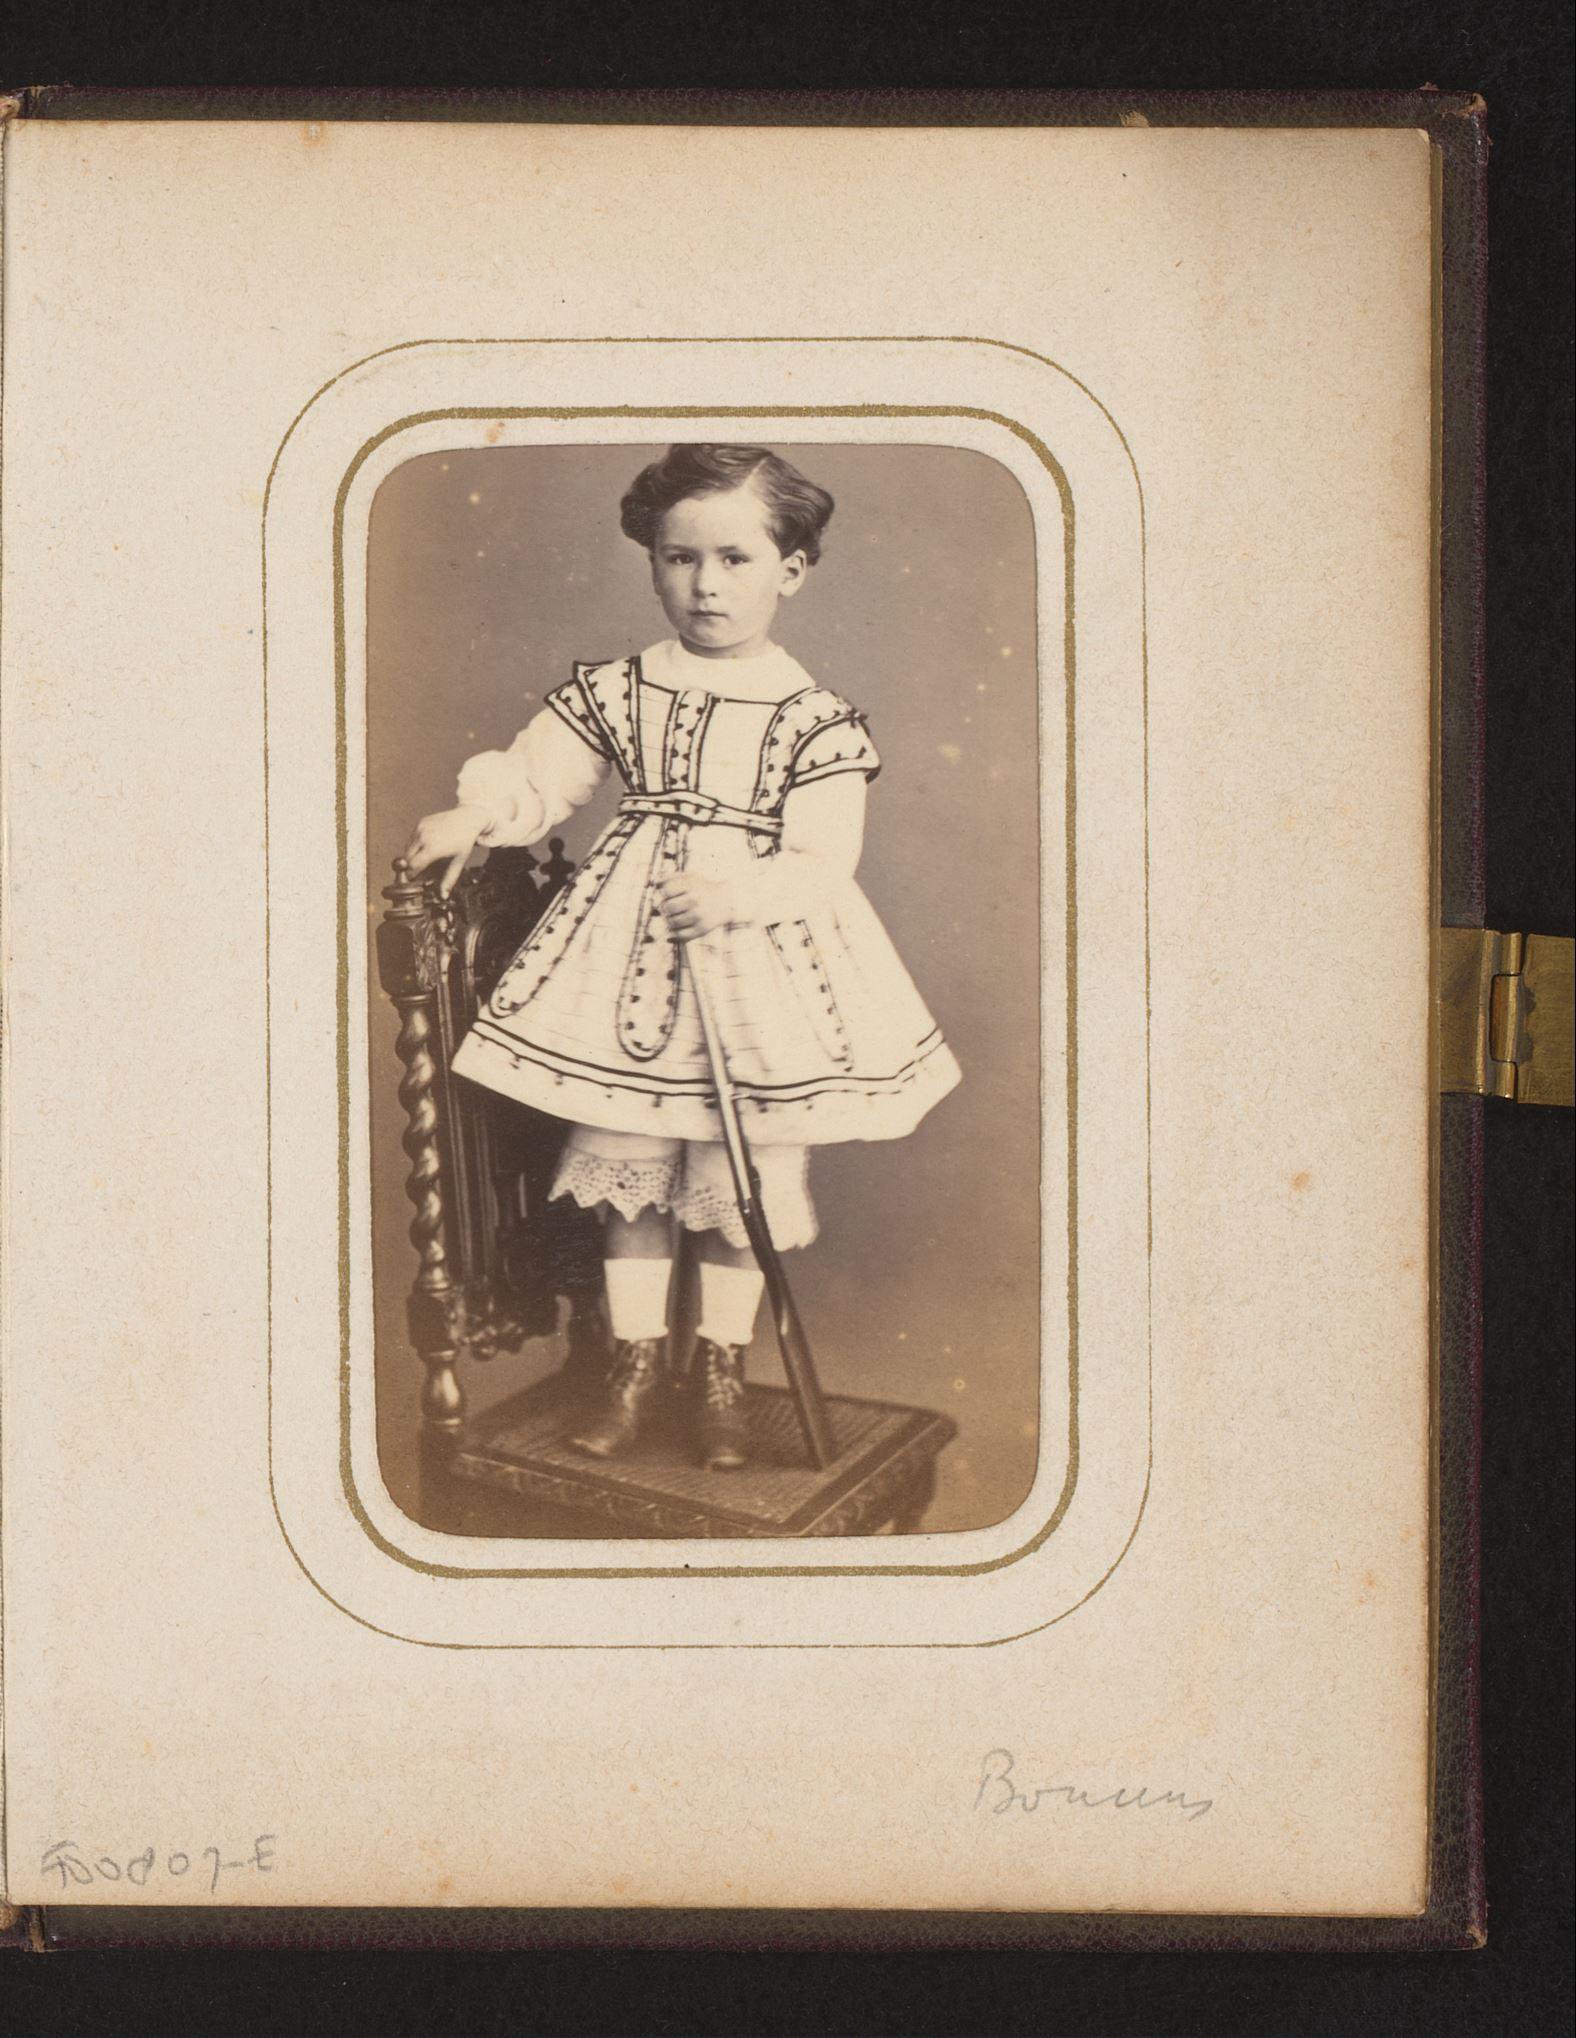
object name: album leaf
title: Portret van een meisje, staand op een stoel met geweer in de hand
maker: jean bourens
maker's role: fotograaf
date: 1860-1900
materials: cardboard, photographic support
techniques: albumen print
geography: metz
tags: historical persons - bb - woman, girl (child between toddler and youth), firearms: rifle, chair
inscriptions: annotation: ‘Bourens’, inscription: ‘J. BOURENS/ Photographe/ METZ/ RUE SERPENOISE, No 27 & 29.’